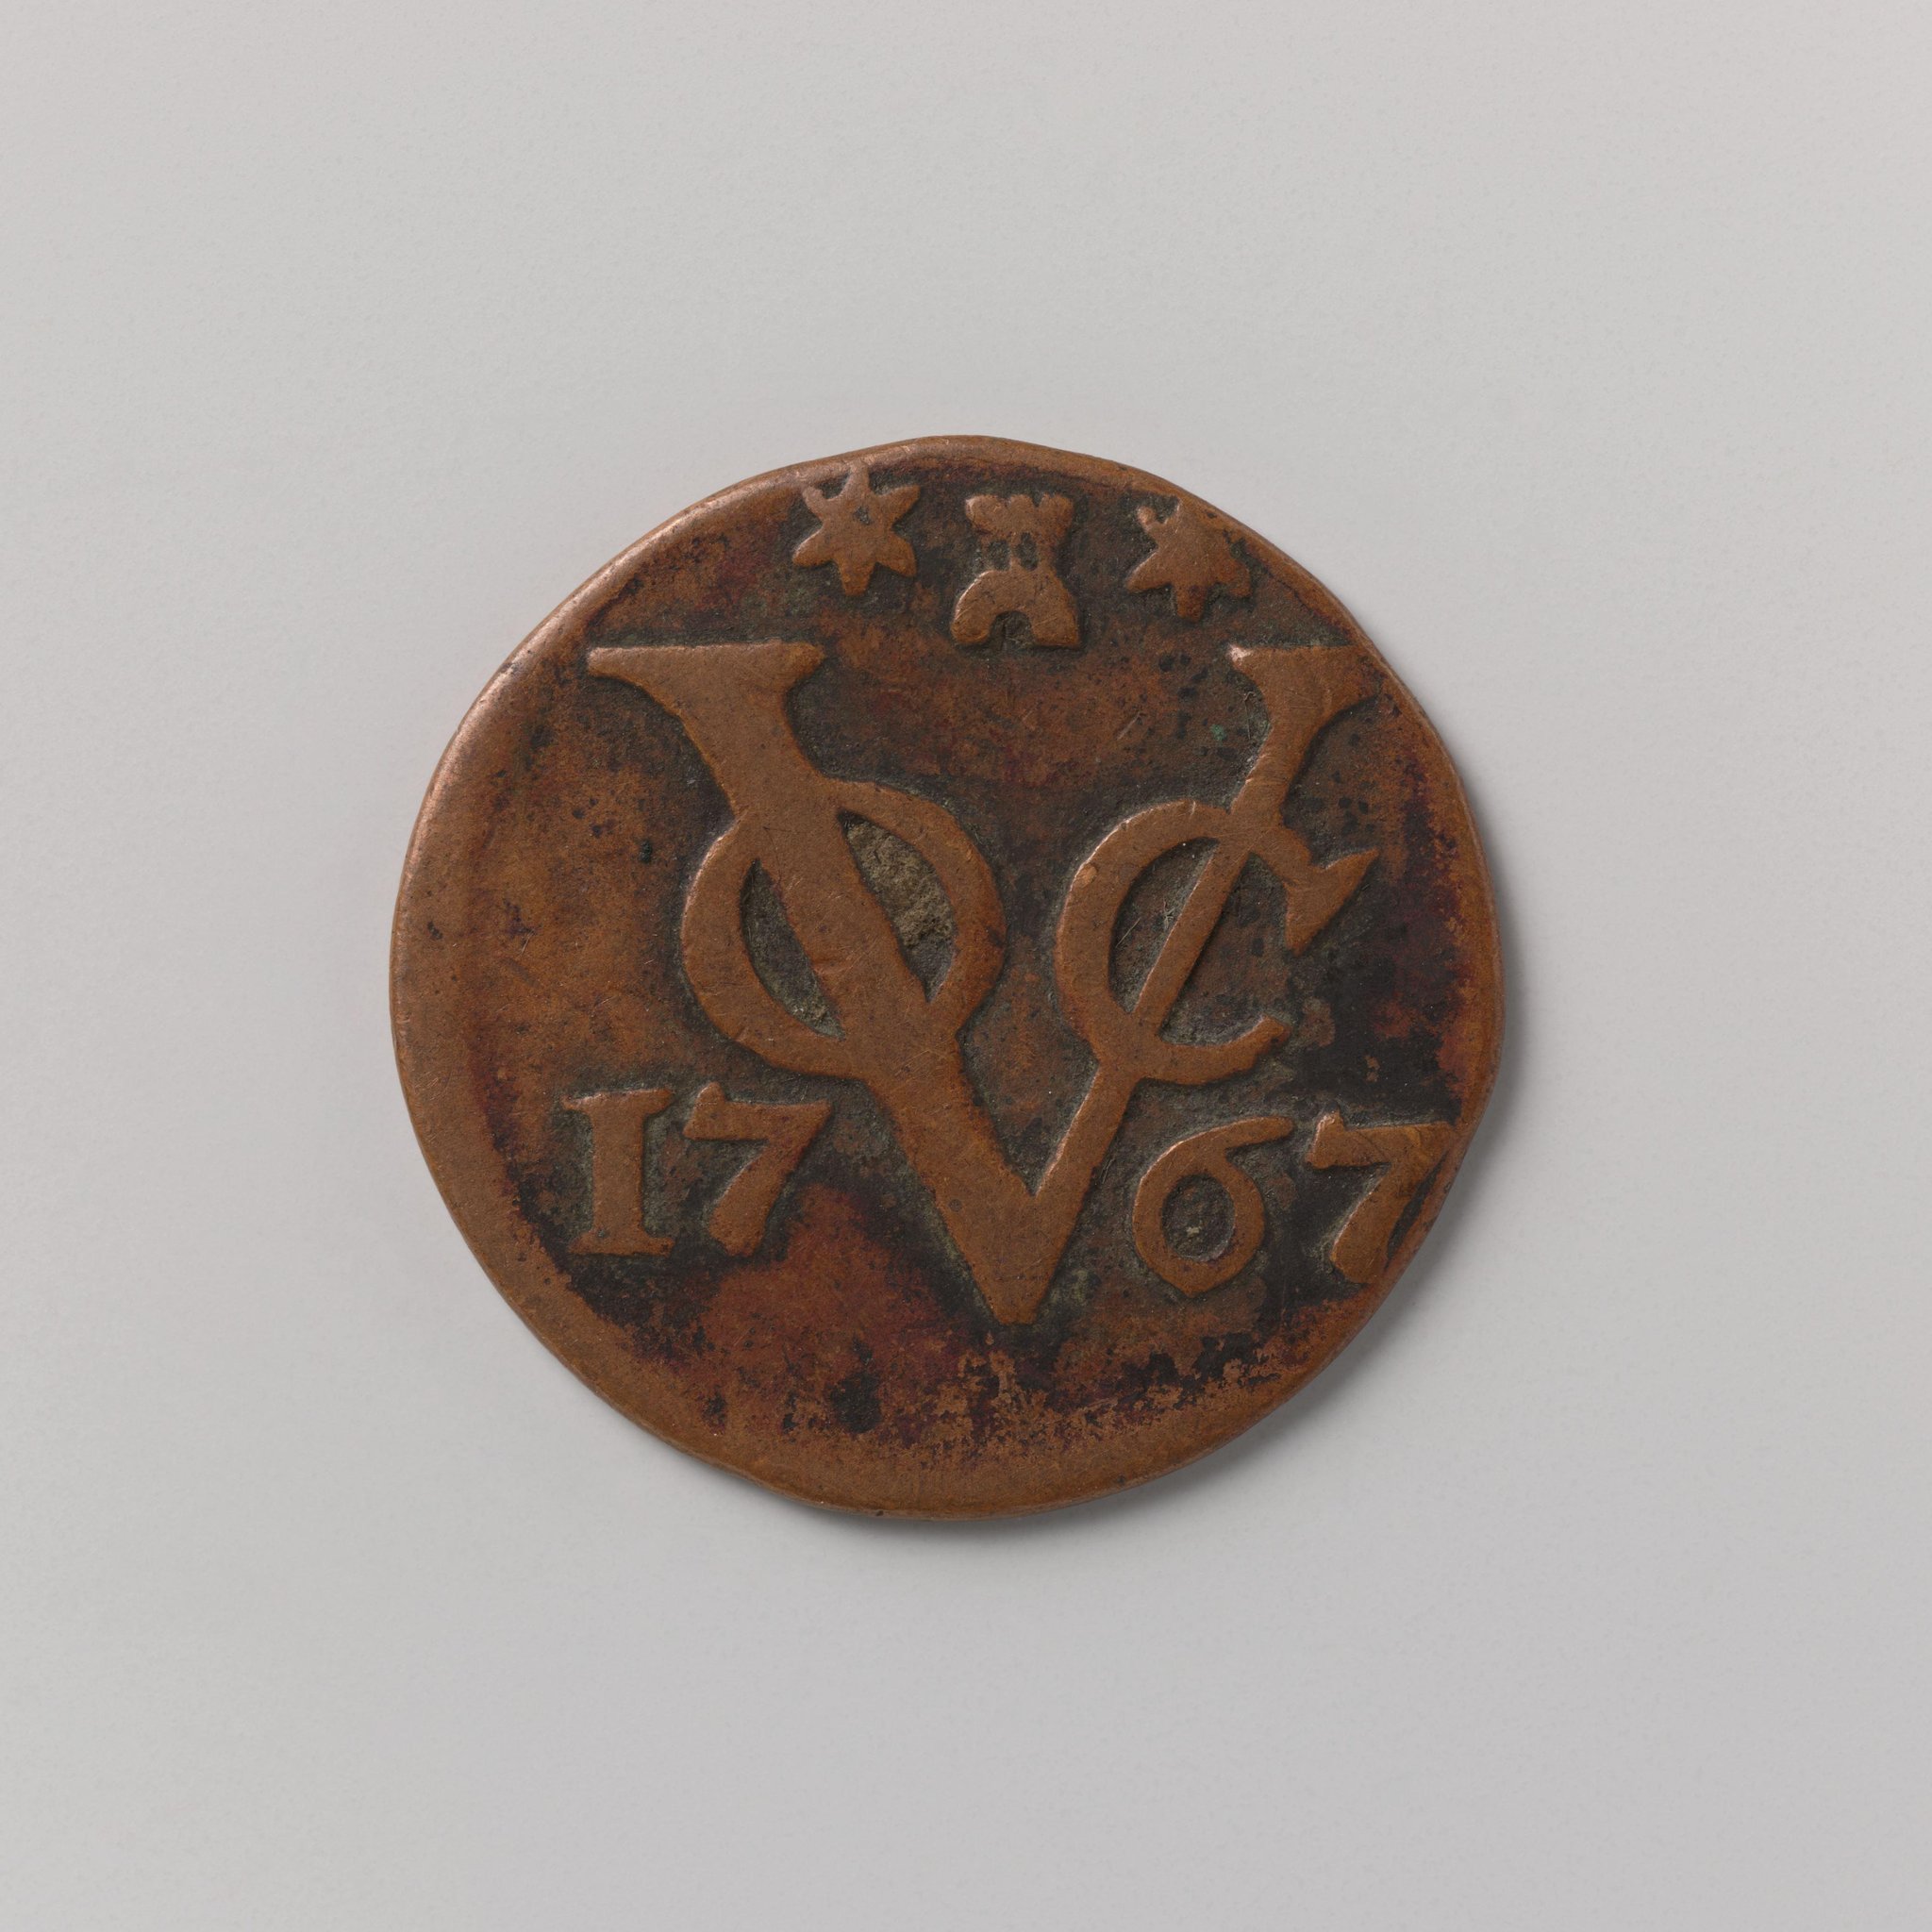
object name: coin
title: VOC, duit Zeeland, 1767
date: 1767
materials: copper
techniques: striking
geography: middelburg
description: Koperen munt. Voorzijde: gekroond wapenschild van Zeeland. Keerzijde: monogram van de VOC, waarboven muntteken en waaronder jaartal. Gladde rand.